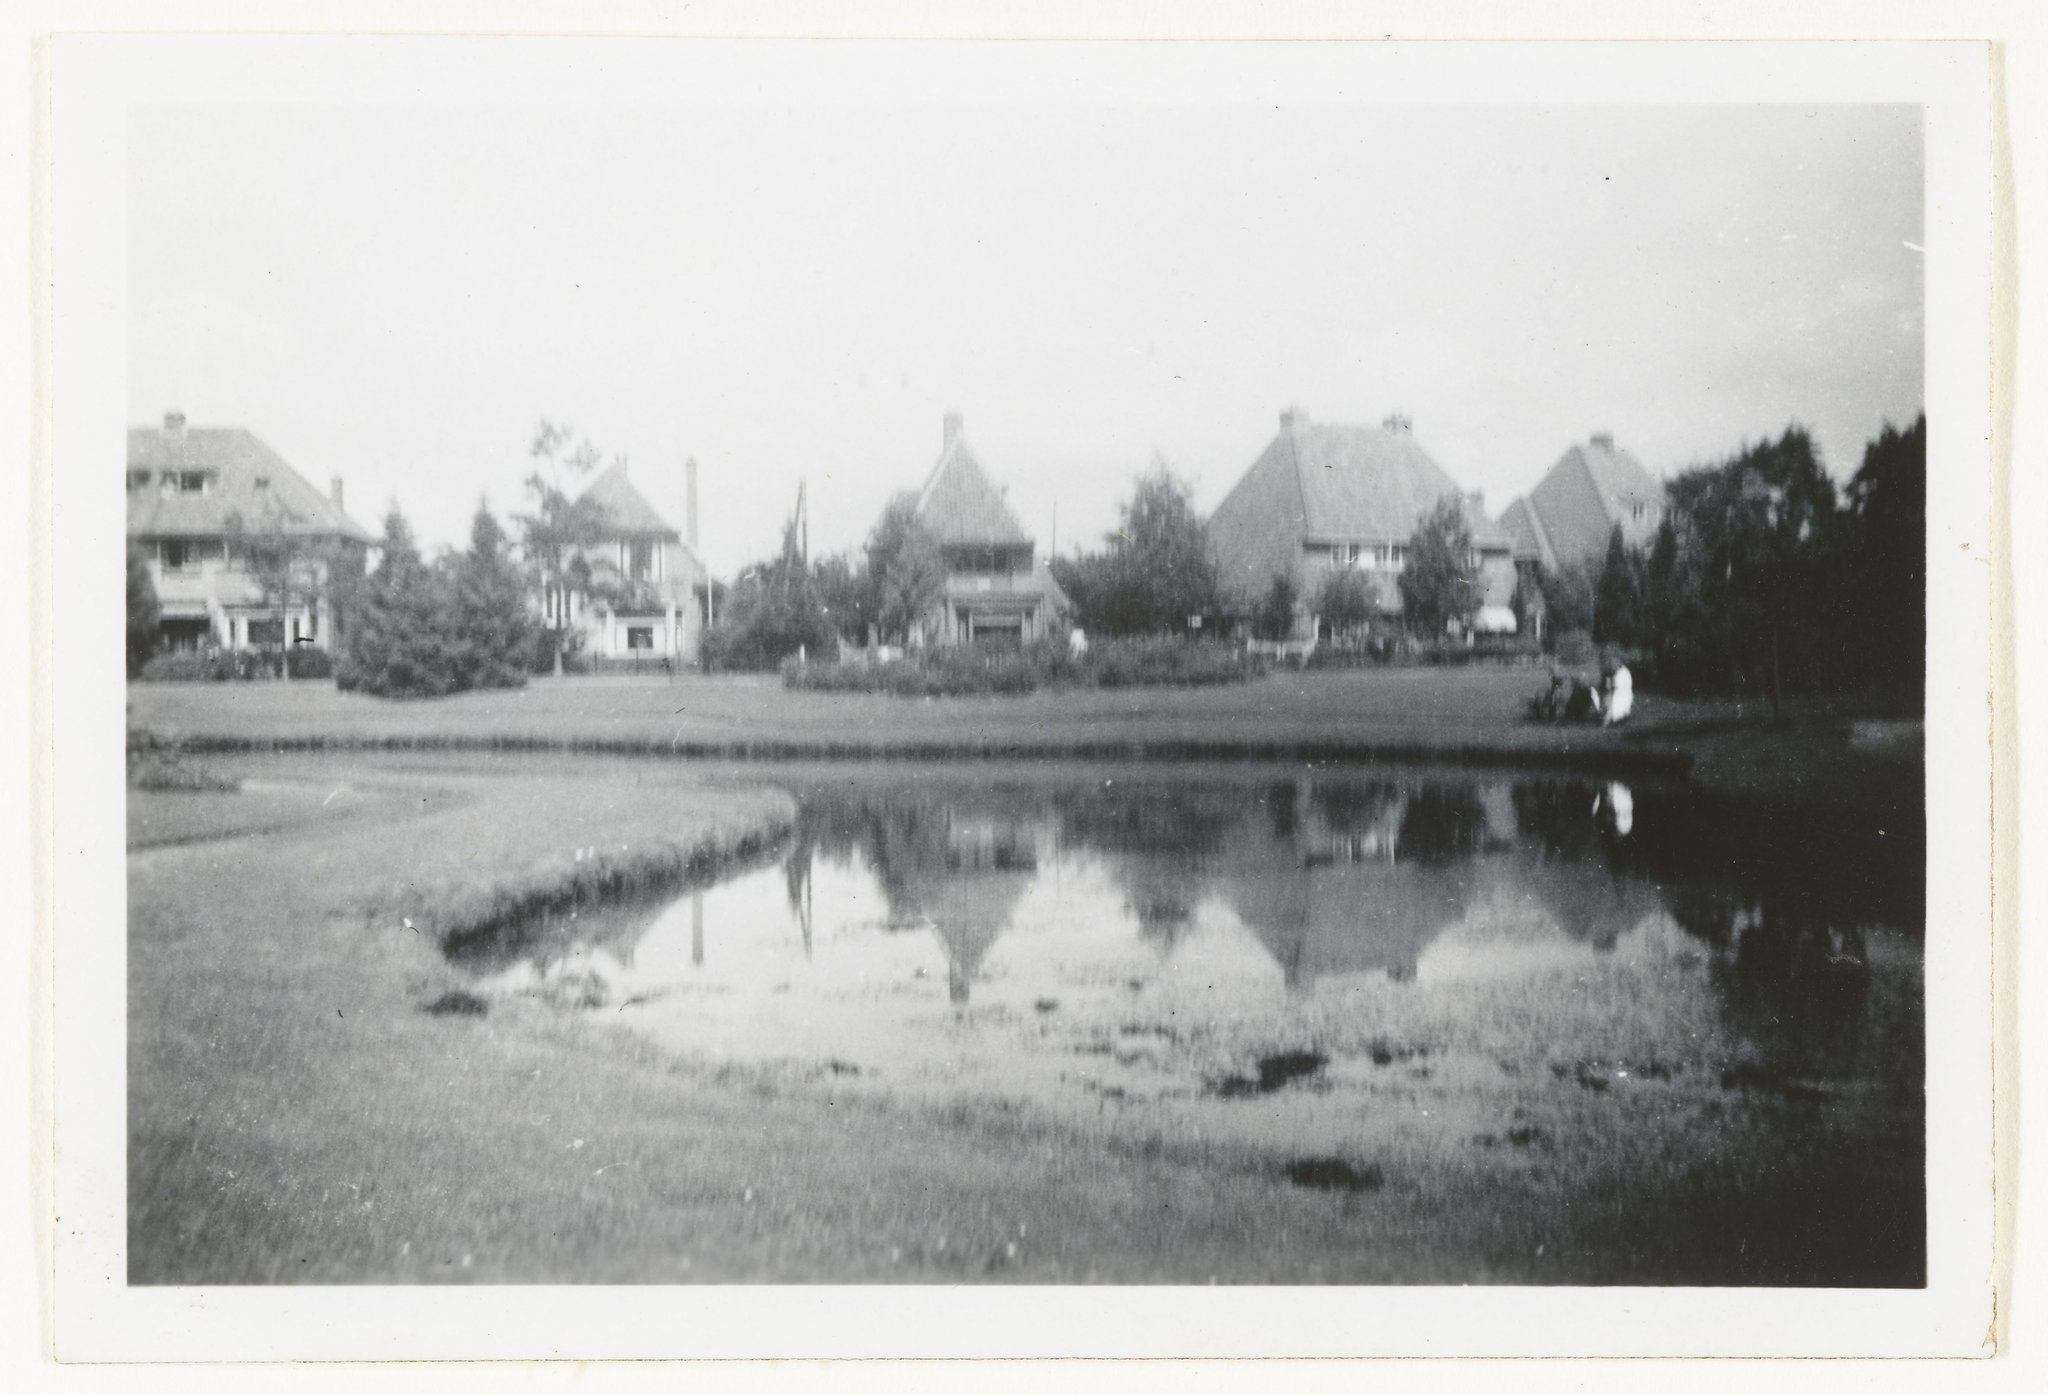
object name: photograph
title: Villawijk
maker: Anonymous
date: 1940-1942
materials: photographic support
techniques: gelatin silver print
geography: netherlands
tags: occupation ~ war, netherlands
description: Een villawijk aan het water. Links een paar mensen in het gras